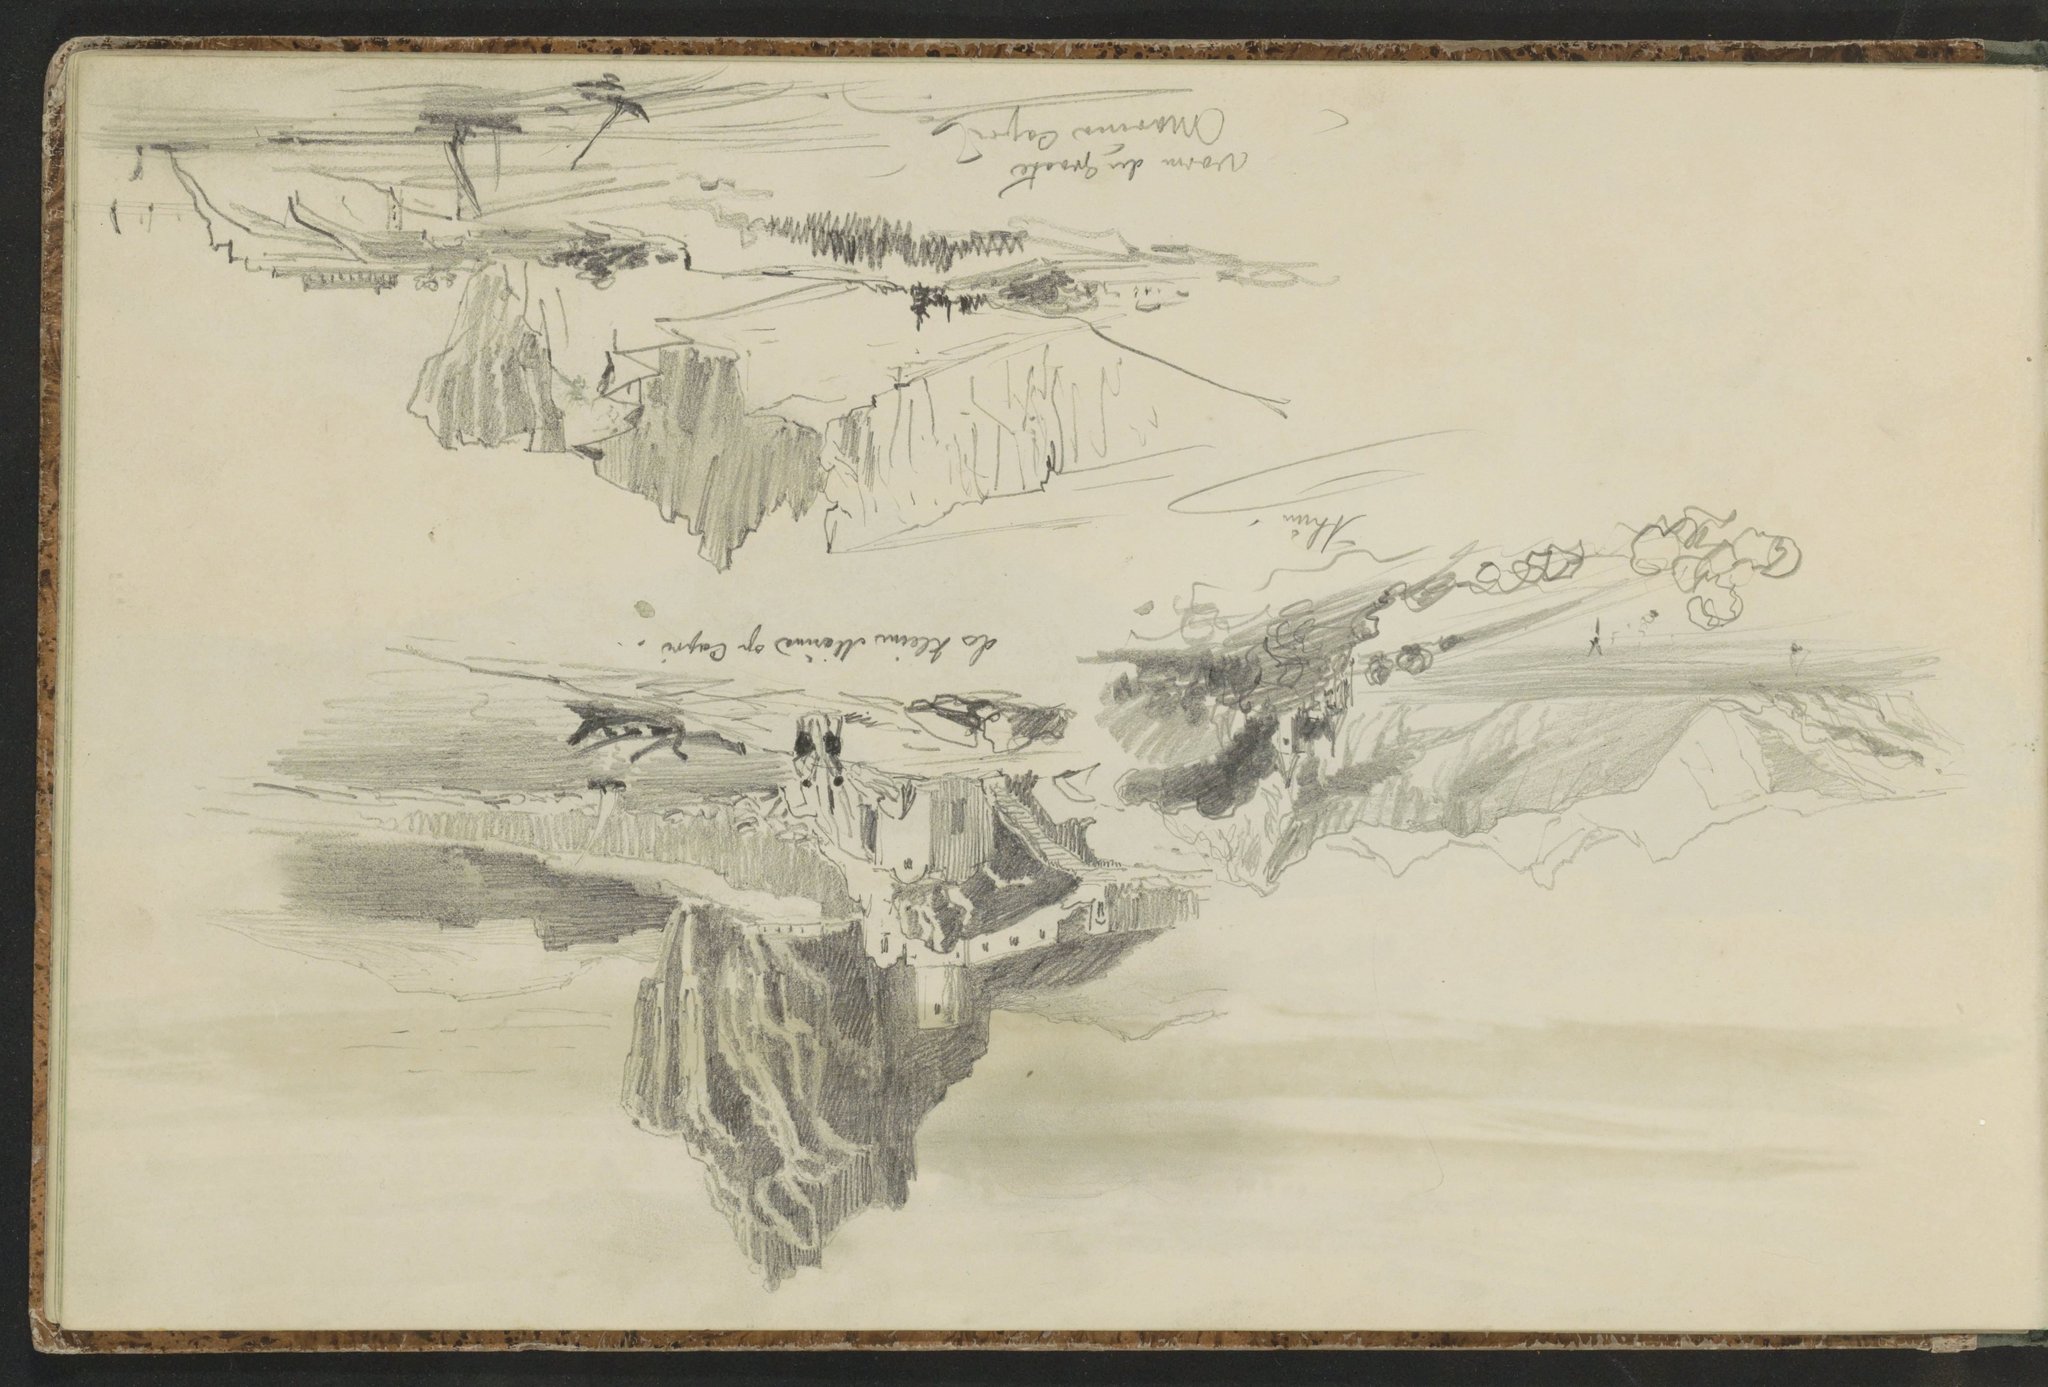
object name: sketchbook leaf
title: Grote en kleine marina op Capri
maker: johannes tavenraat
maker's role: draughtsman, painter, print maker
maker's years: 1809-1881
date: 1840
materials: paper, pencil, watercolor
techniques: brush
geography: capri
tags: harbour, sailing-ship, sailing-boat, mountains, capri, isola di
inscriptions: annotation: ‘de kleine Marina op Capri./ vorm der grote/ Marina Capri’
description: Blad 8 verso uit een schetsboek met 33 bladen.